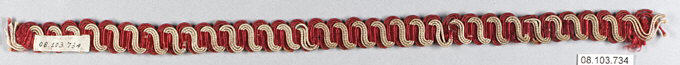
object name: gimp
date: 1701-1900